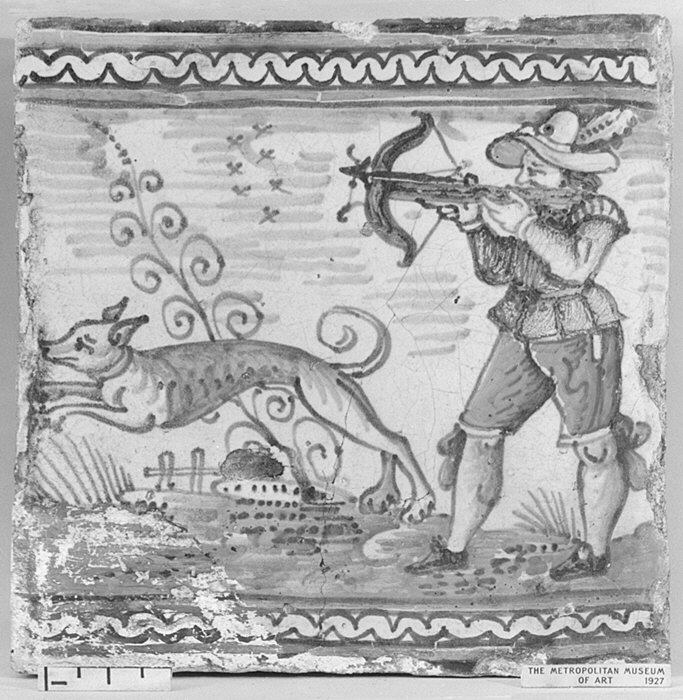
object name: tile from a frieze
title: Frieze tile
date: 1600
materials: earthenware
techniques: glazing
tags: hunting,dogs